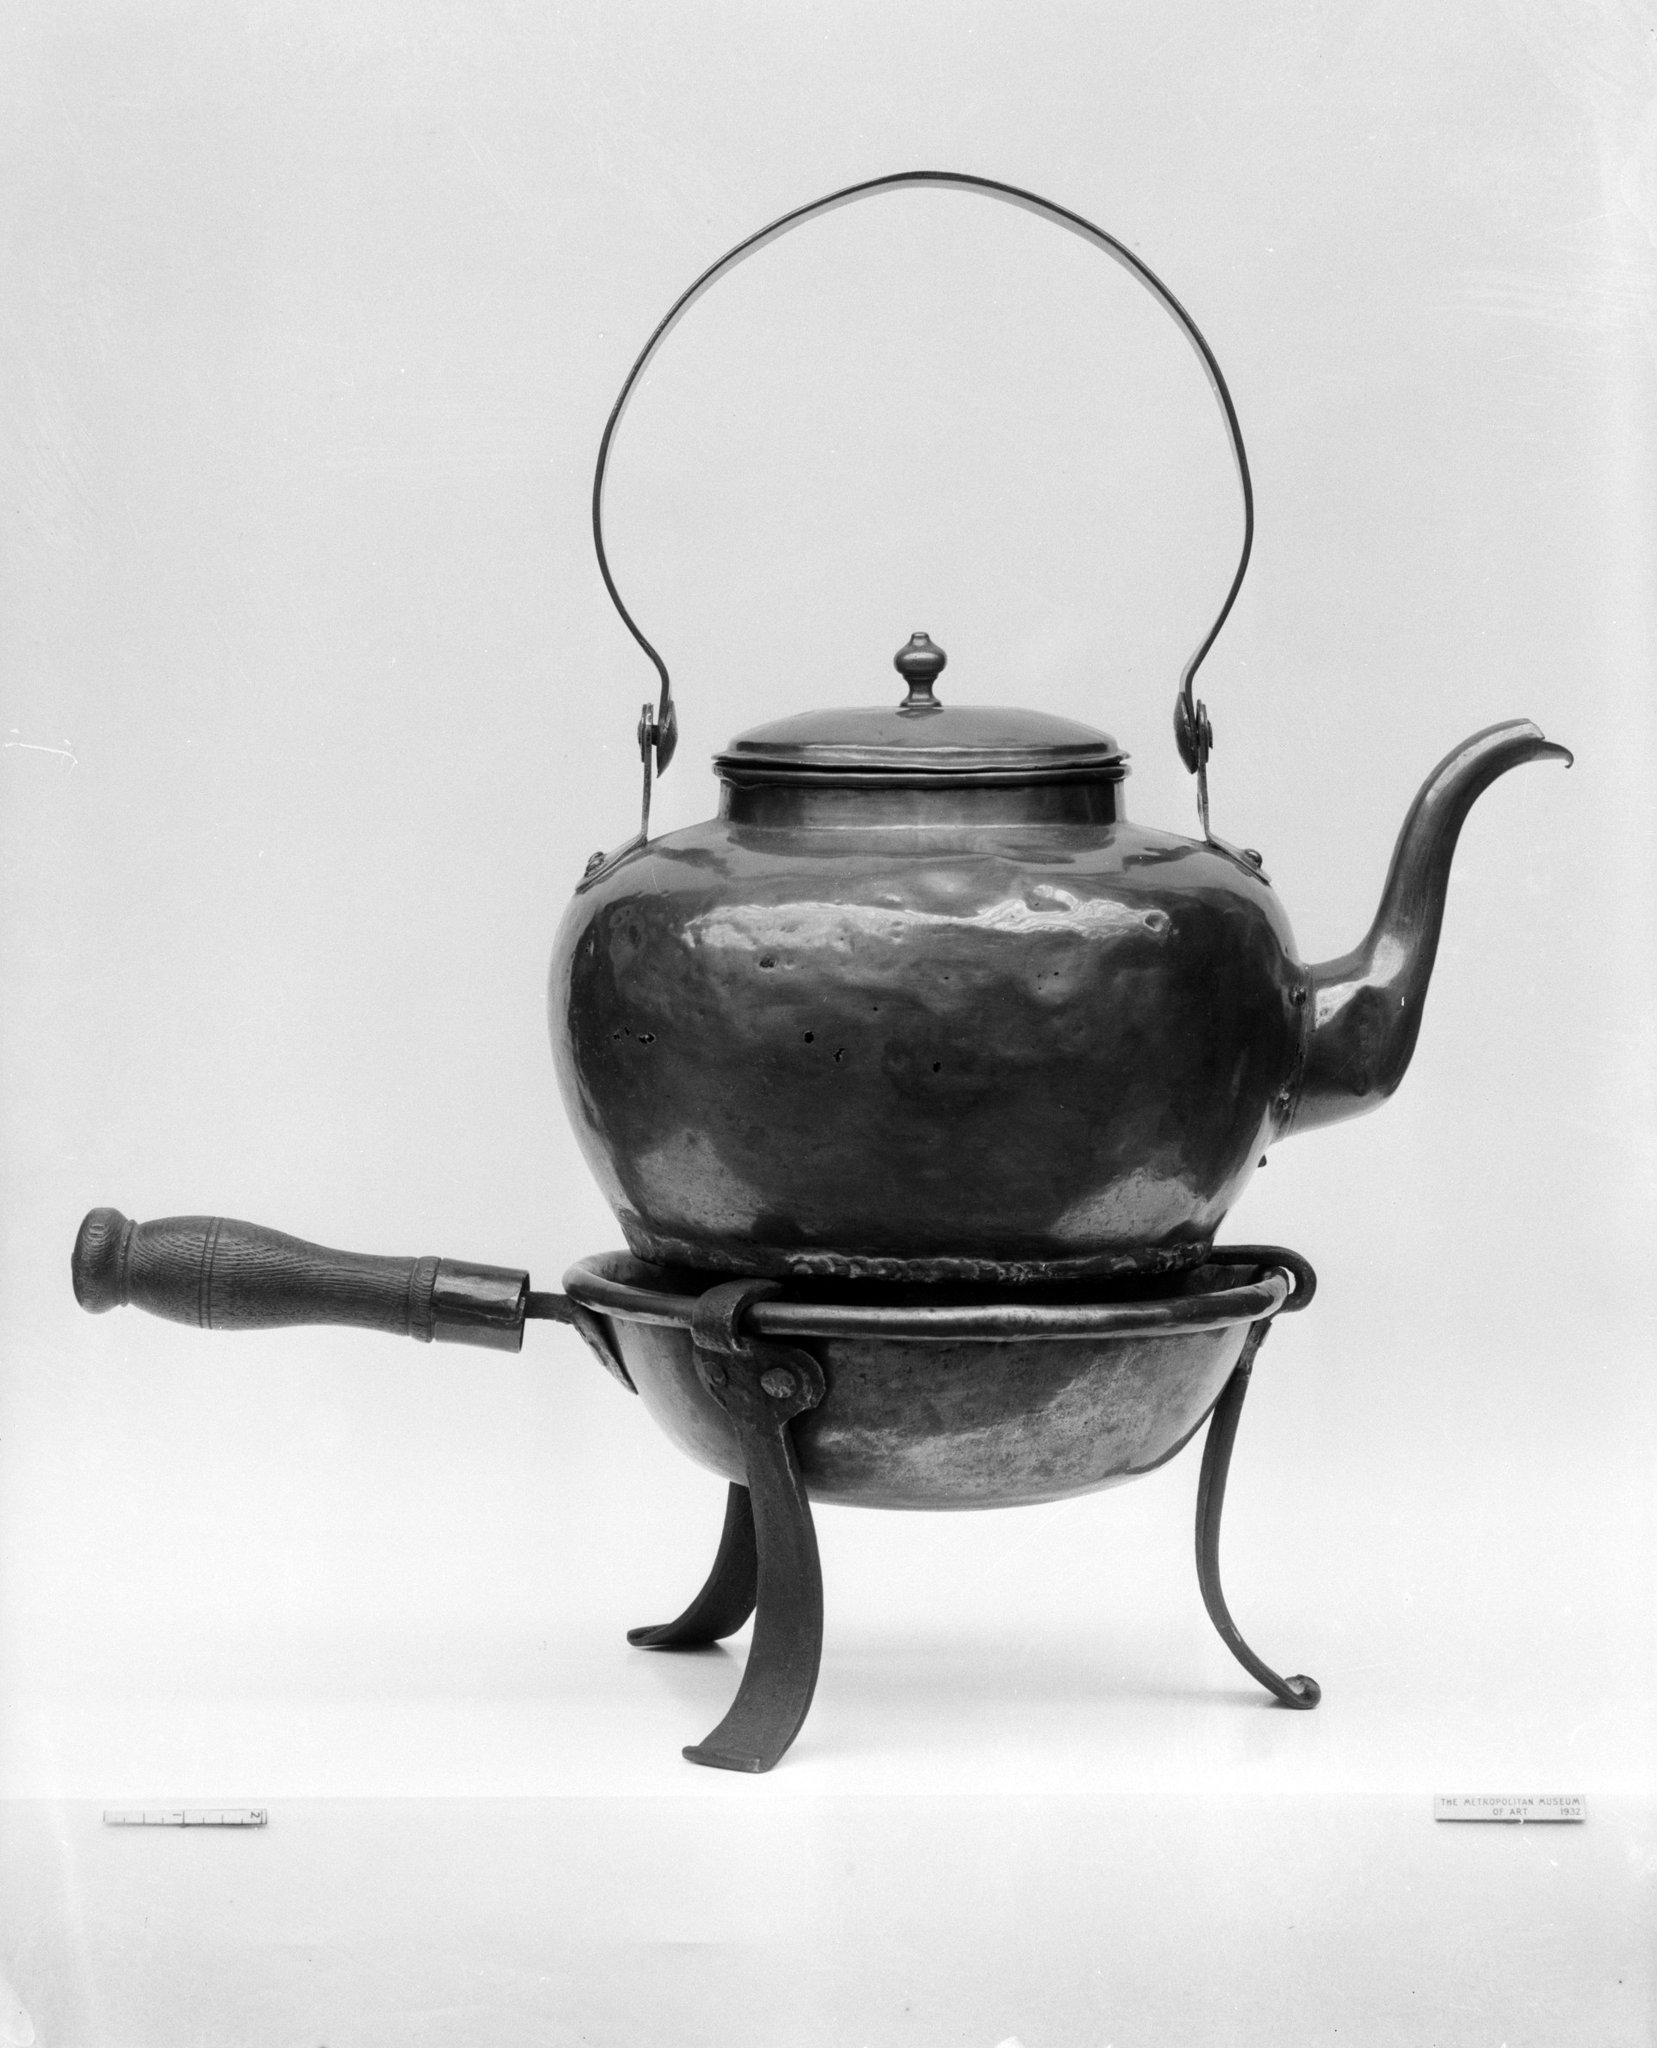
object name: teakettle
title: Covered Teakettle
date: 1700-1800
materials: copper